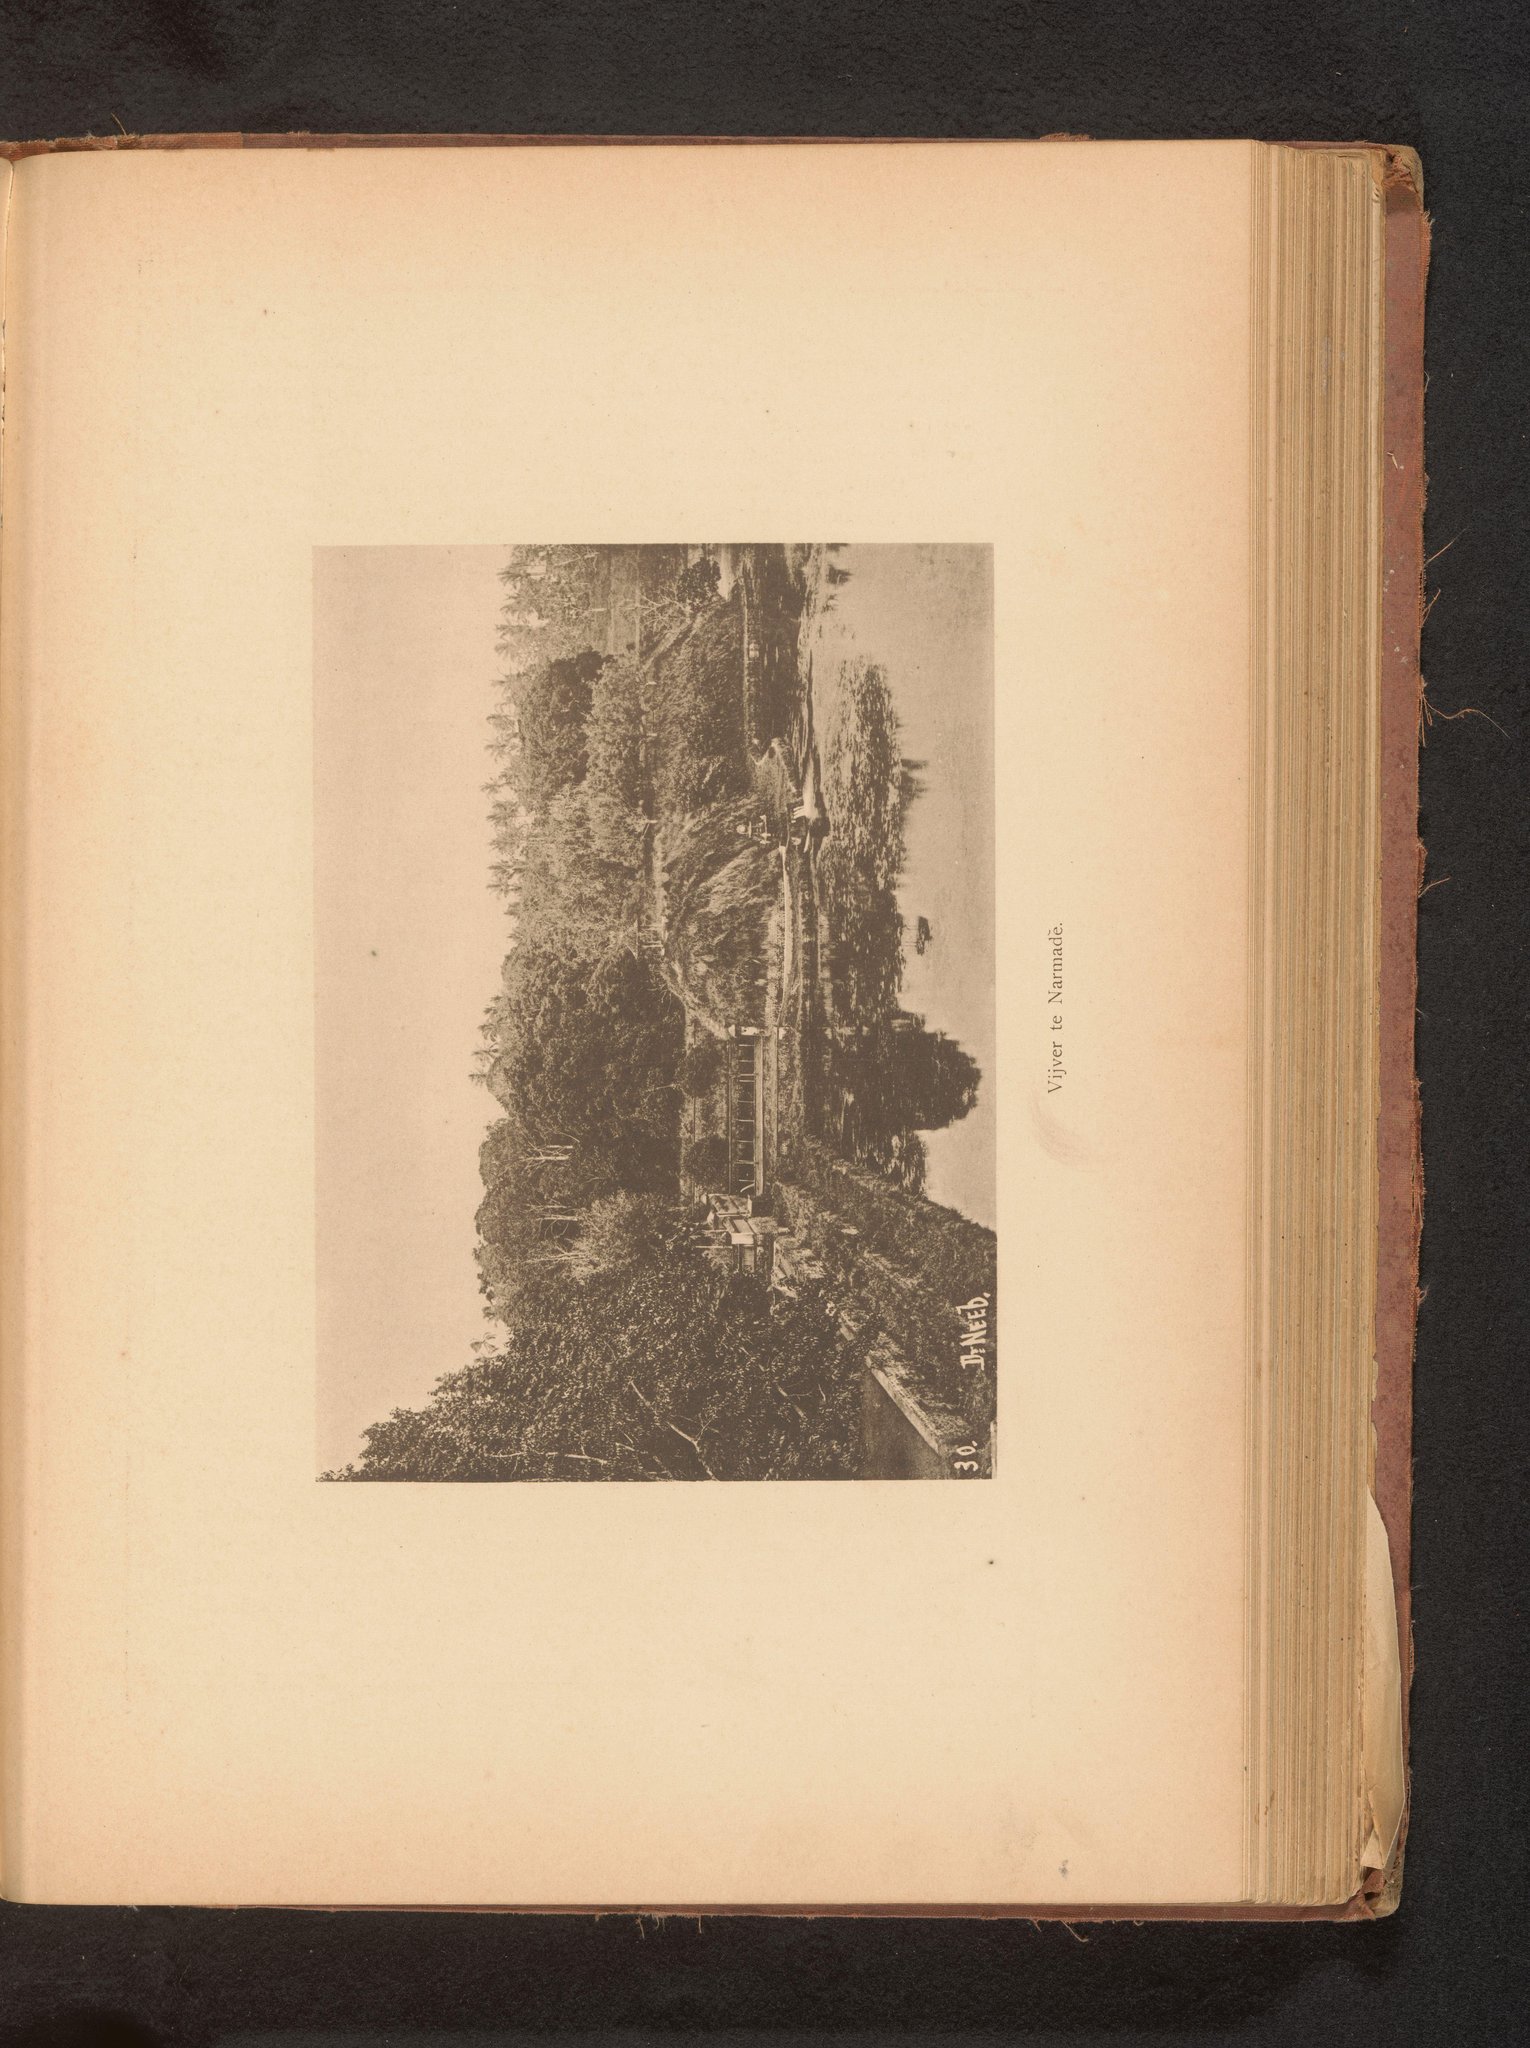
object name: page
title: Gezicht op een water te Narmada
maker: christiaan johan neeb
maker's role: arts, fotograaf, officier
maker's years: 1860-1925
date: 1892-1897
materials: paper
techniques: photograph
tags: landscapes with waters, waterscapes, seascapes (in the temperate zone)